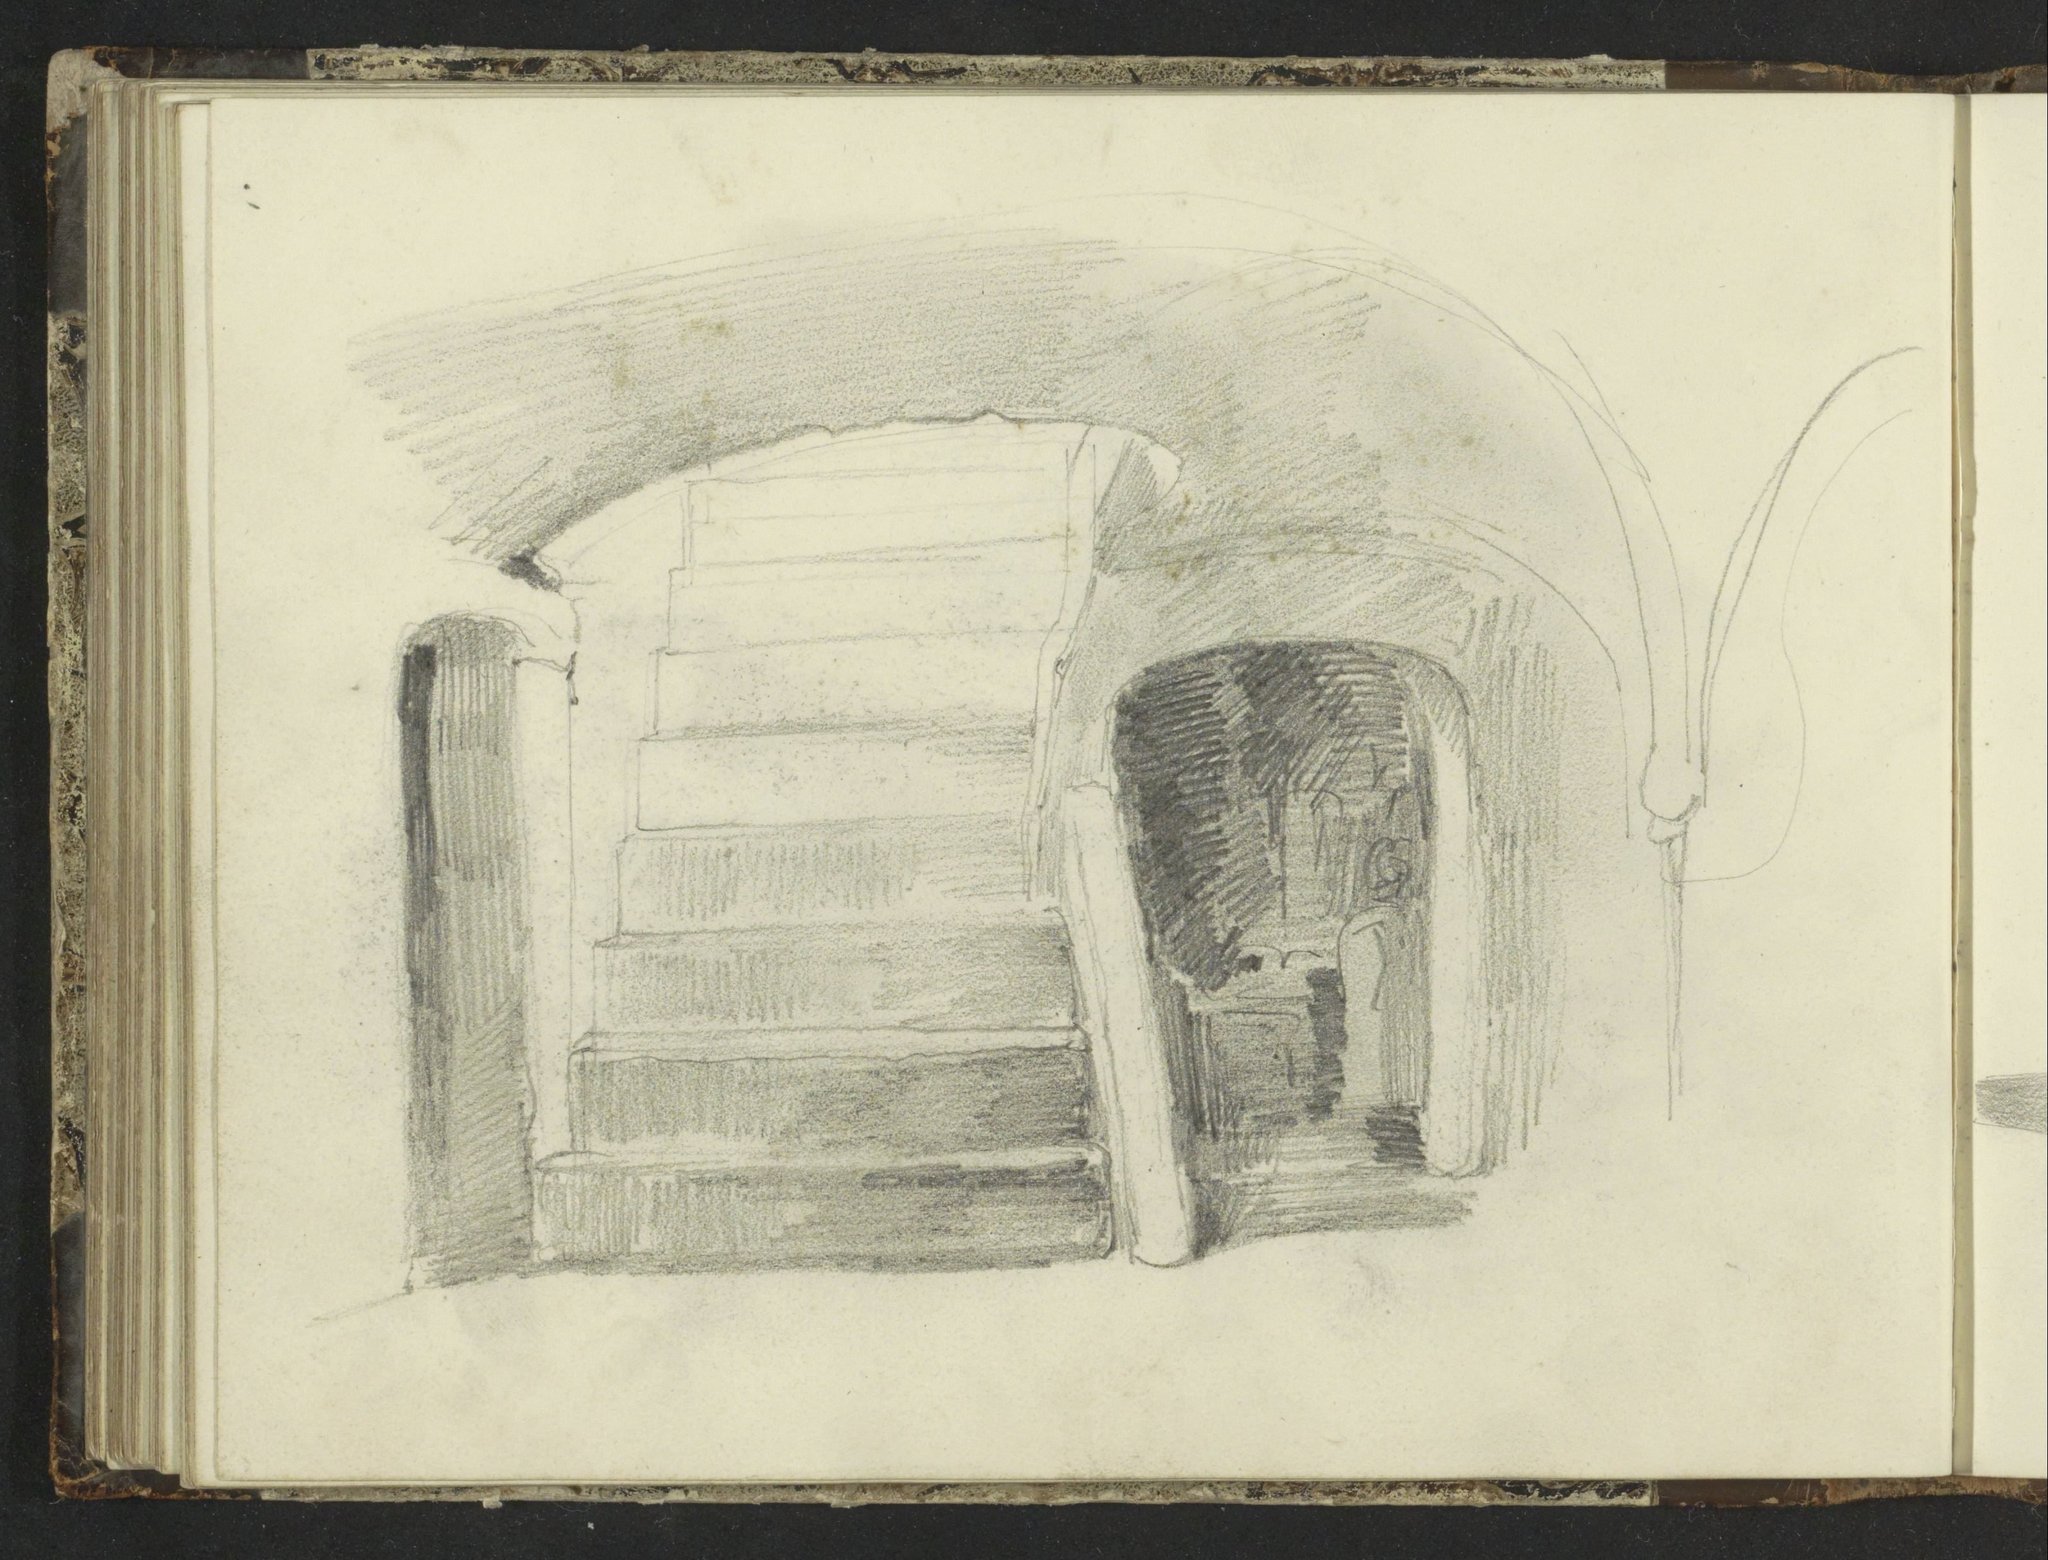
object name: sketchbook leaf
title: Boog met trap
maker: willem hendrik schmidt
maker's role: draughtsman, painter, print maker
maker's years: 1809-1849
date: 1819-1849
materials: paper, pencil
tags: arch, archivolt ~ architecture, staircase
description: Blad 39 verso uit een schetsboek met 58 bladen.